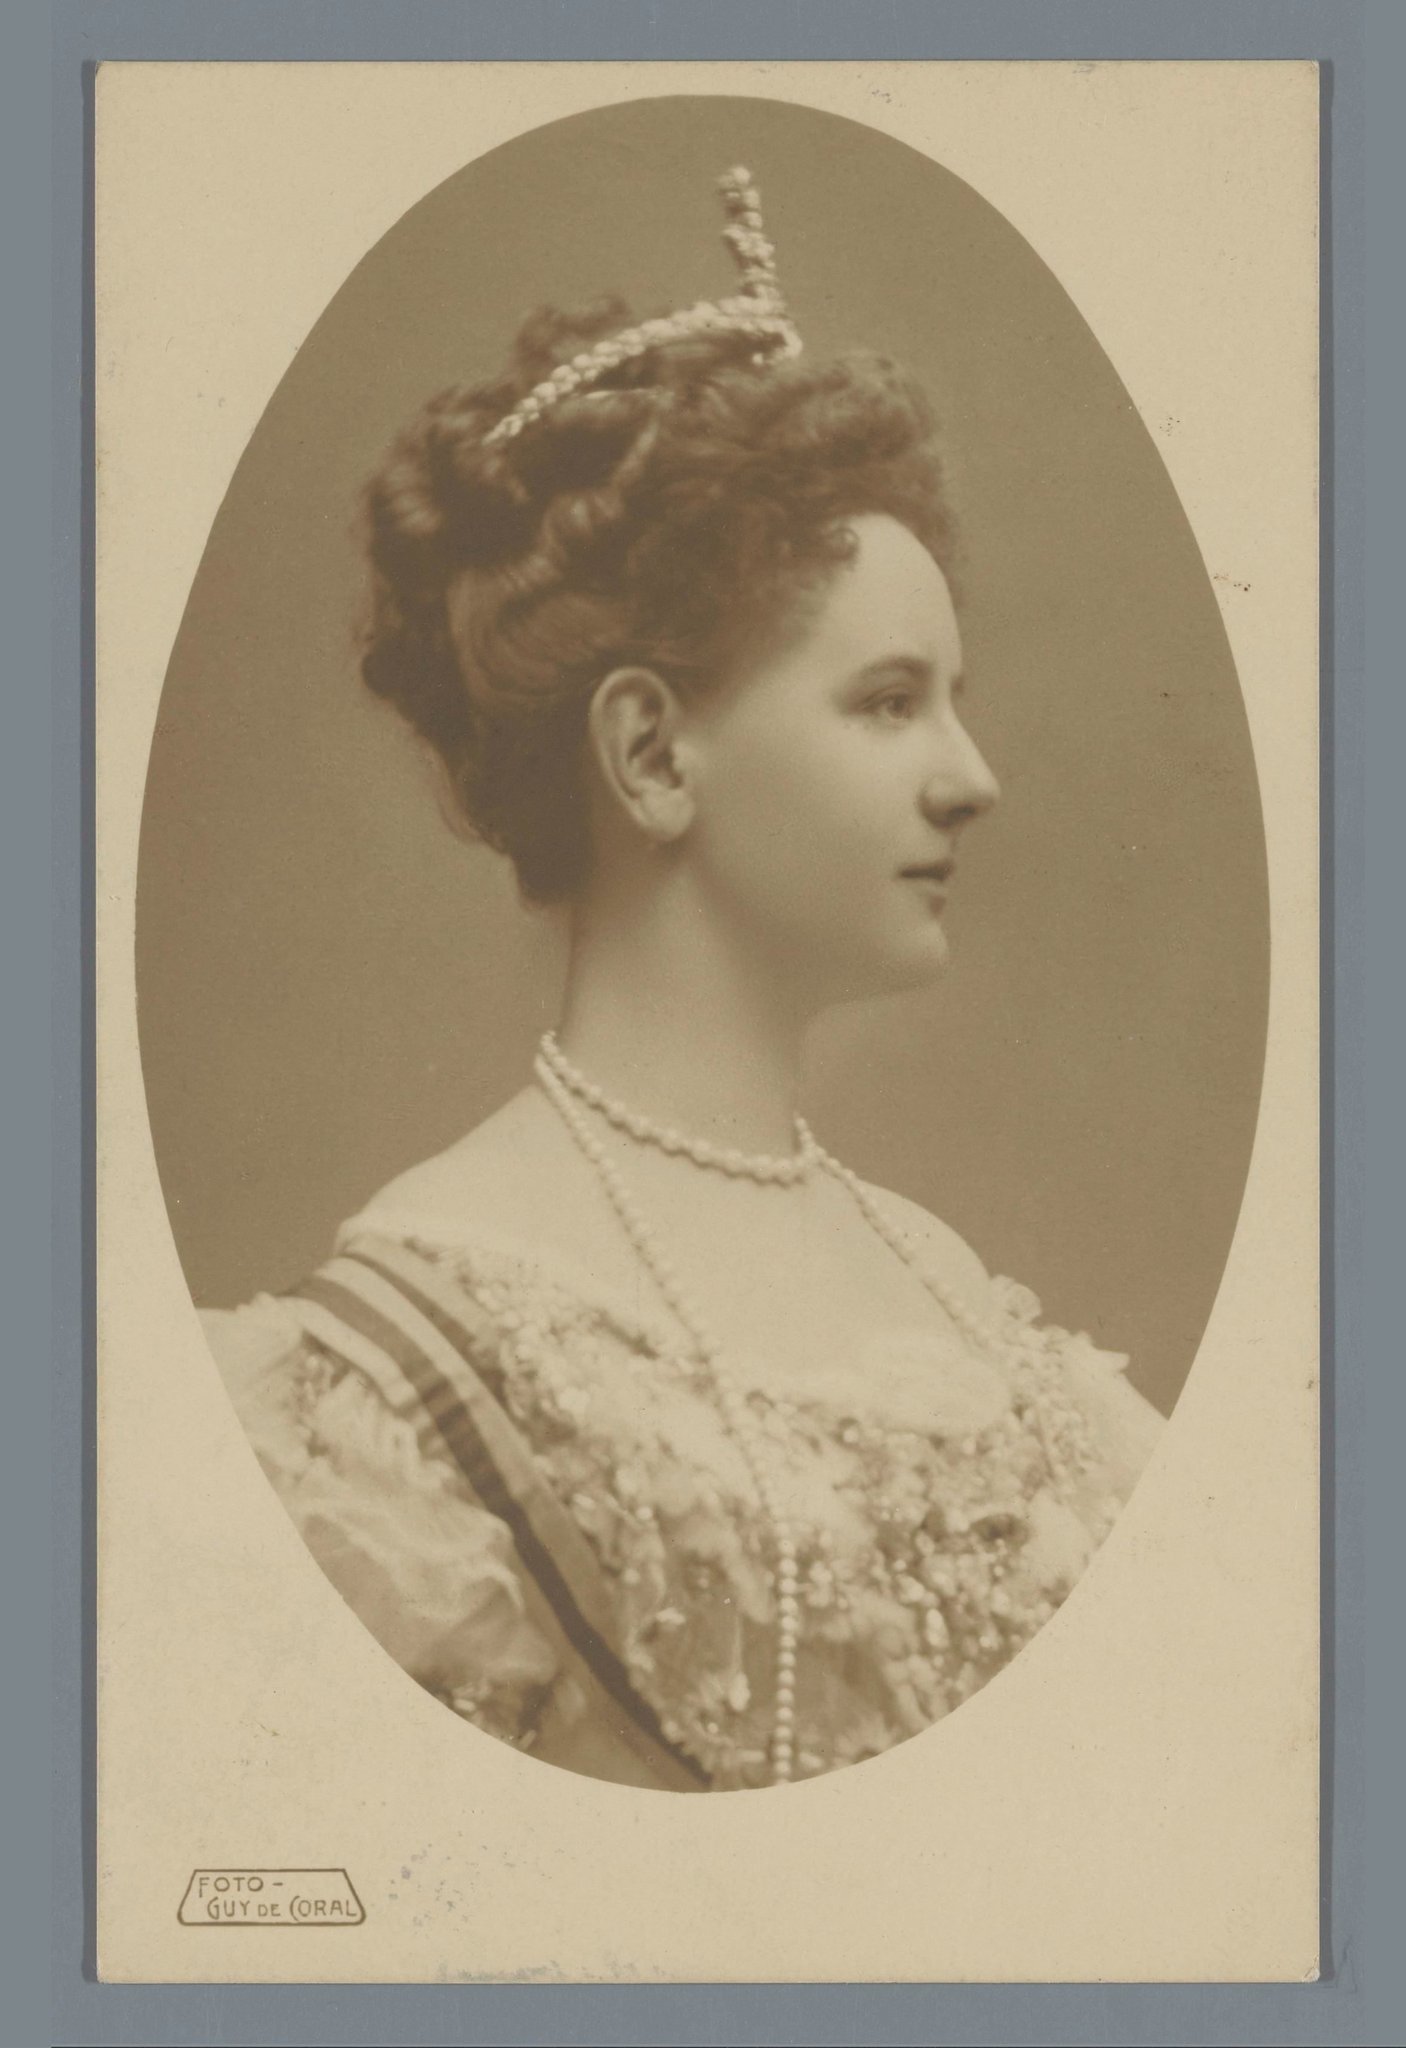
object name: ansichtkaart, prentbriefkaart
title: Portret van koningin Wilhelmina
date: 1908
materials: photographic support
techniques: writing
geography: netherlands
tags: wilhelmina of the netherlands, historical persons, queen, diadem, tiara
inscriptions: postage stamp, inscription: ‘FOTO - GUY DE CORAL’